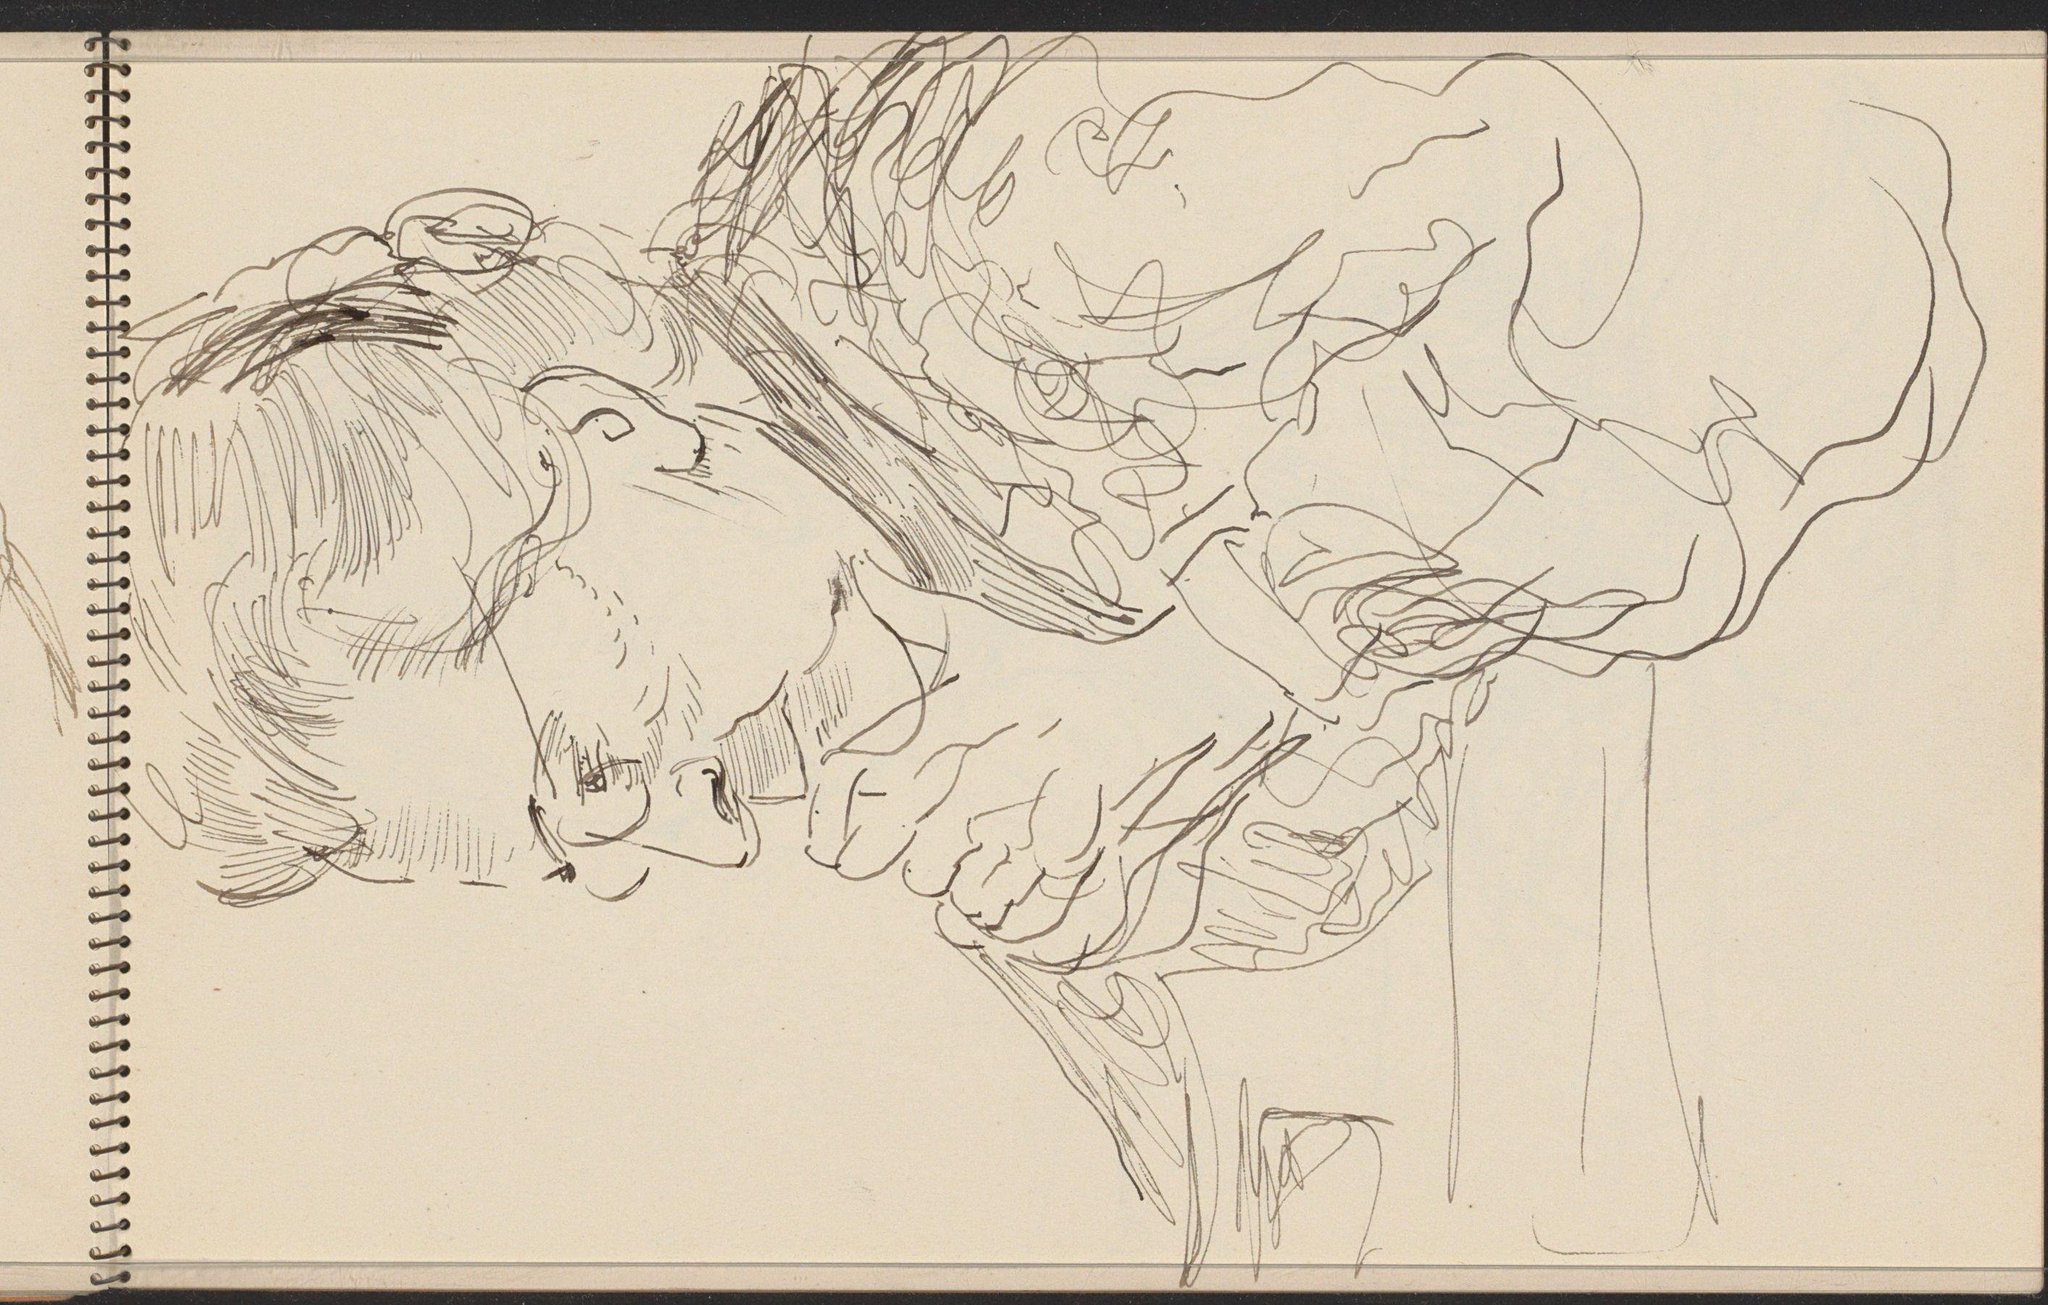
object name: sketchbook leaf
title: Joanna Lion Cachet-Cordes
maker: carel adolph lion cachet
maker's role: draughtsman, print maker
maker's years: 1864-1945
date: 1935-1940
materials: ink, paper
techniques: pen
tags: eyeglasses, spectacles, head (human) (+ female (human being) (not to be used where -aa- is prescribed)), hand(s) bent towards the head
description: Lion Cachet-Cordes houdt haar rechterhand tegen haar kin. Blad 14 recto uit een schetsboek met 25 bladen.